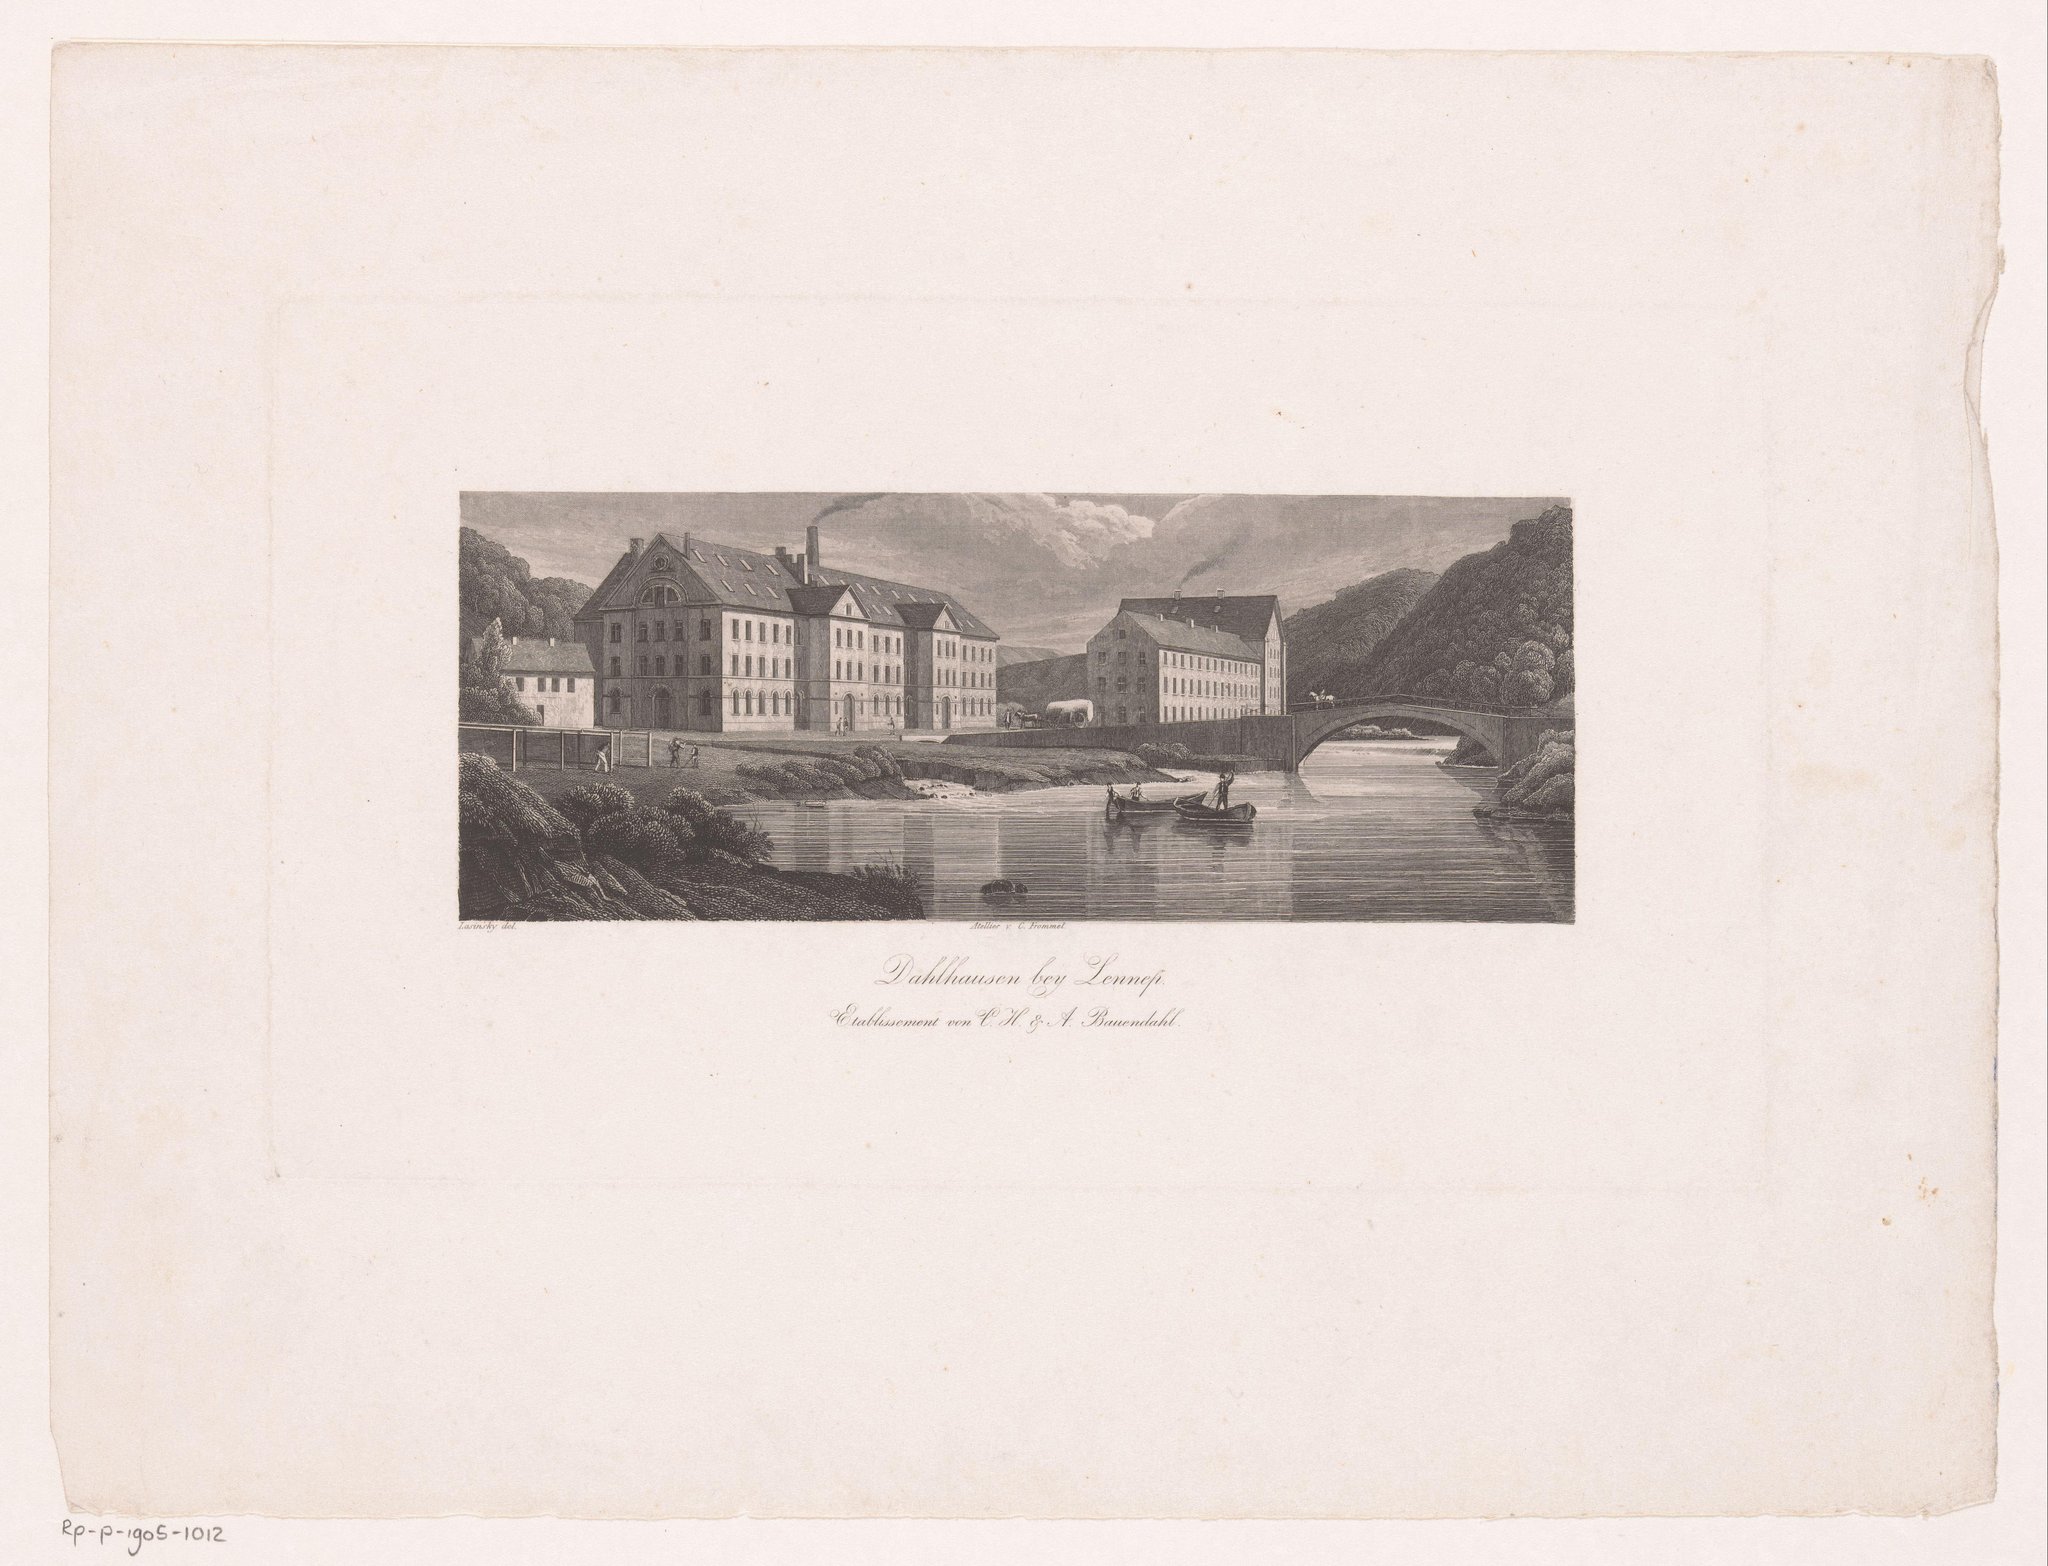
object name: print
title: Gezicht op Dalhausen vanaf de rivier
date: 1799-1863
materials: paper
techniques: etching, engraving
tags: city-view, and landscape with man-made constructions, river, bridge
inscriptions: collector's mark: Lugt 2228